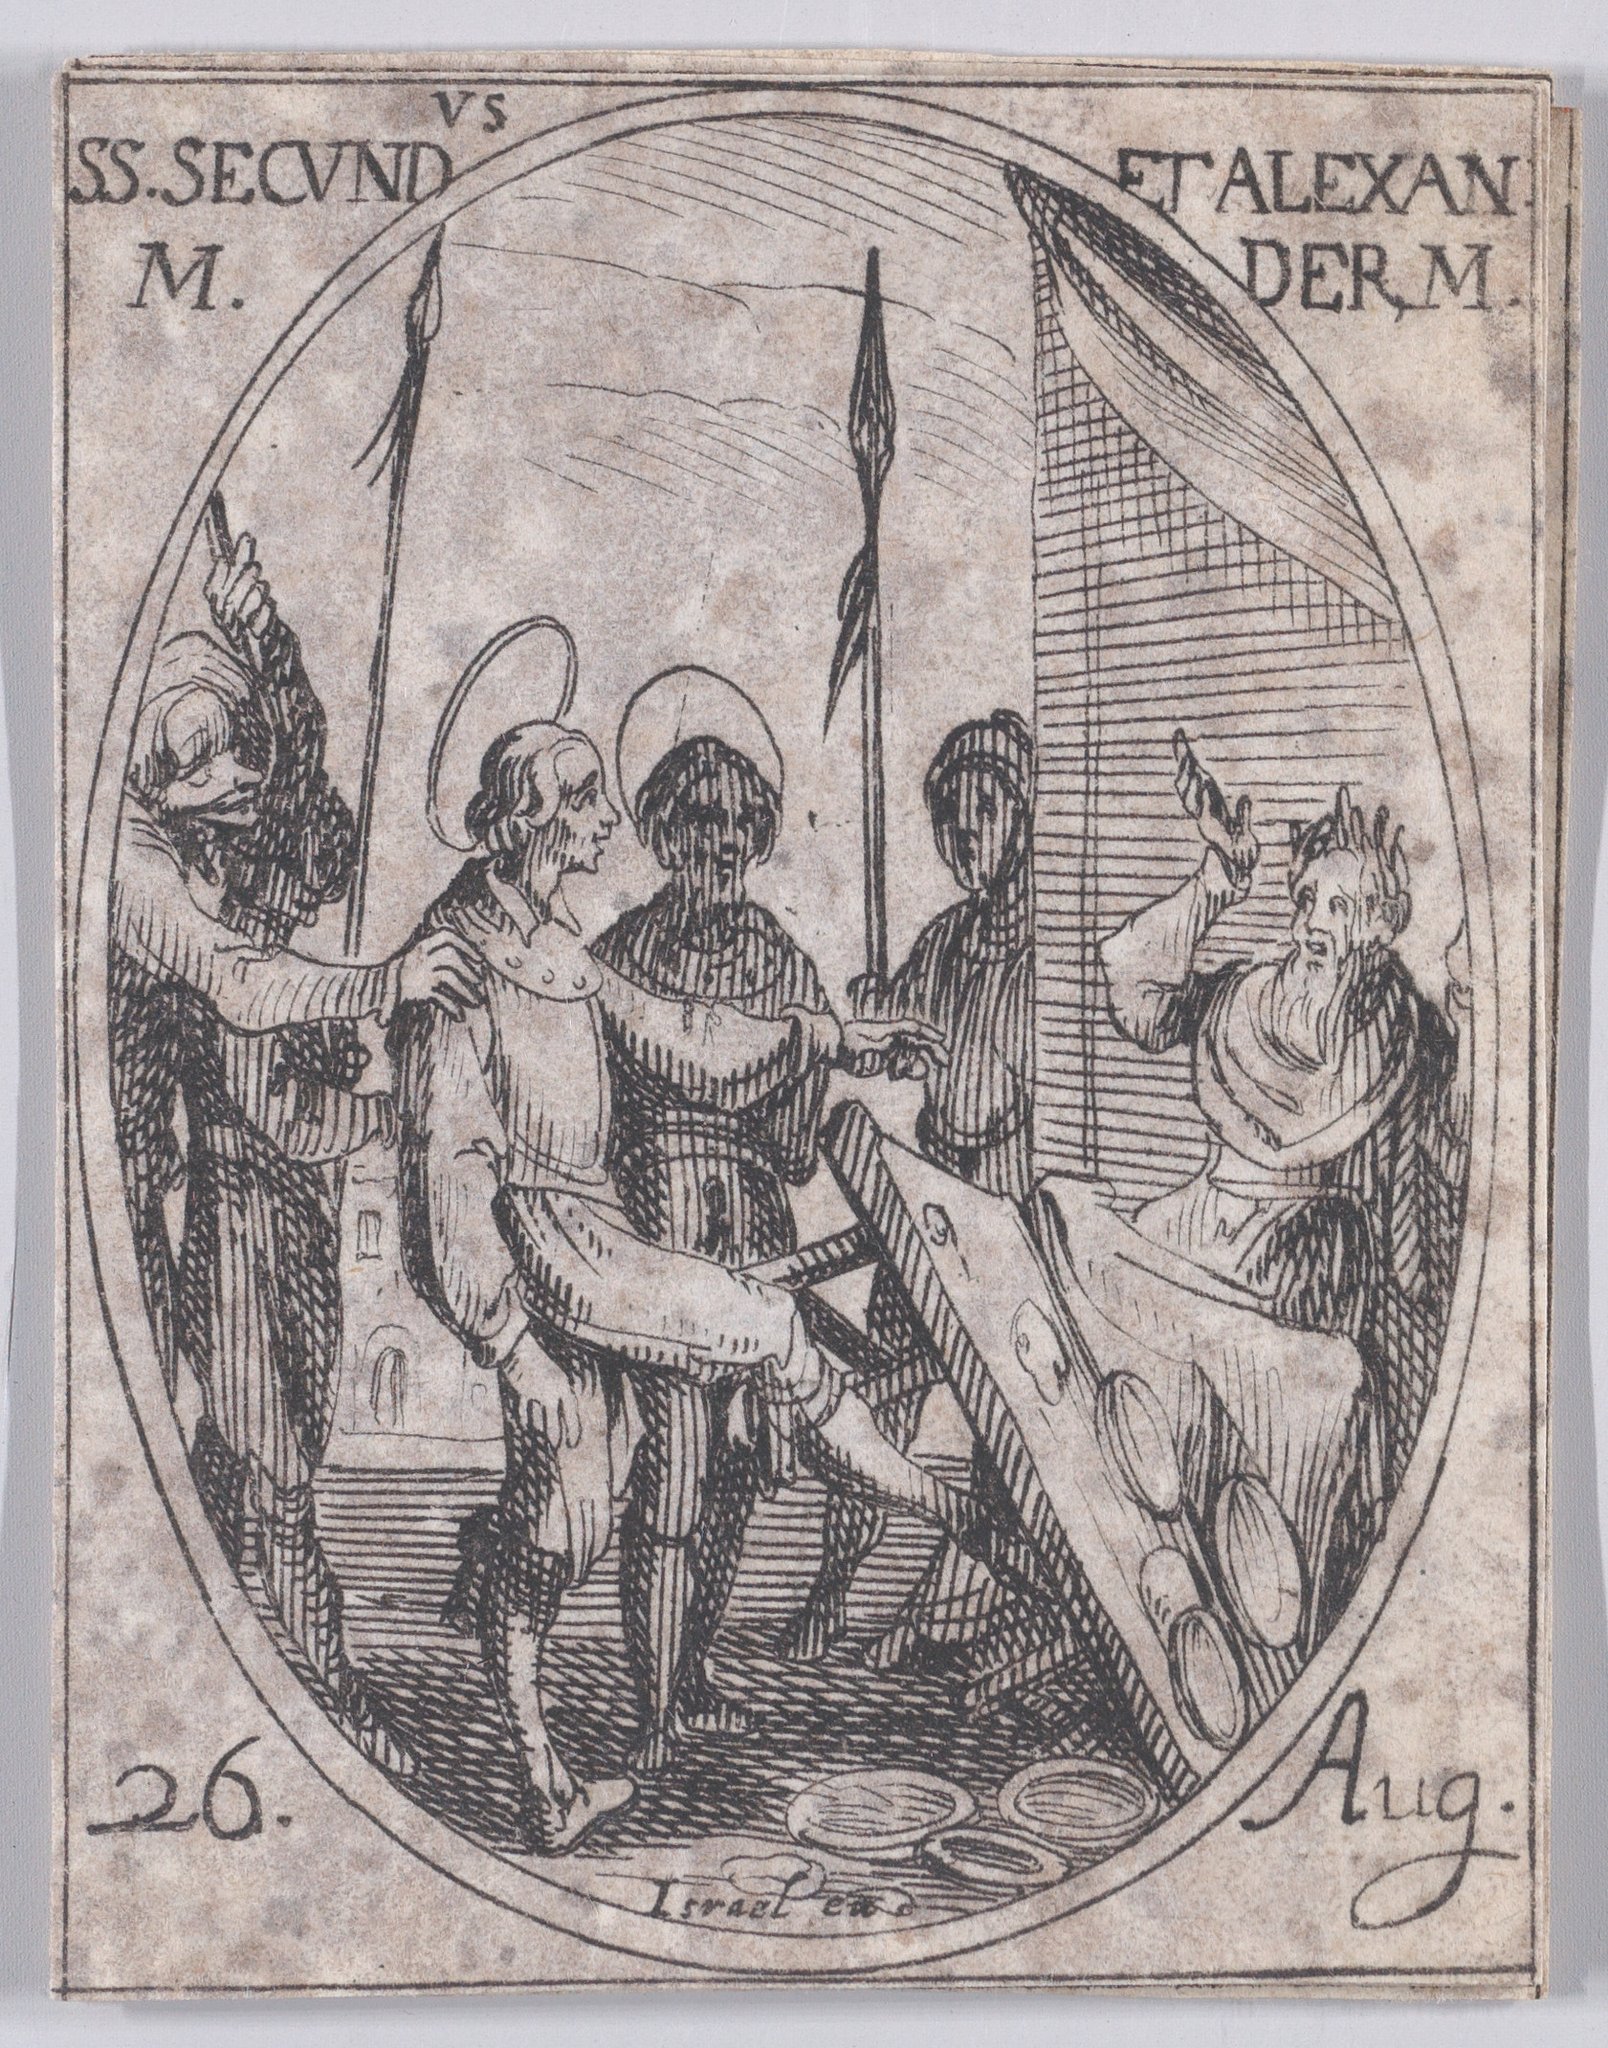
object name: print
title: S. Second et S. Alexandre, martyrs (St. Secundus and St. Alexander, Martyrs), August 26th, from "Les Images De Tous Les Saincts et Saintes de L'Année" (Images of All of the Saints and Religious Events of the Year)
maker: jacques callot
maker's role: artist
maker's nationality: french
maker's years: 1592-1635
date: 1636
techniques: etching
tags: men,saints